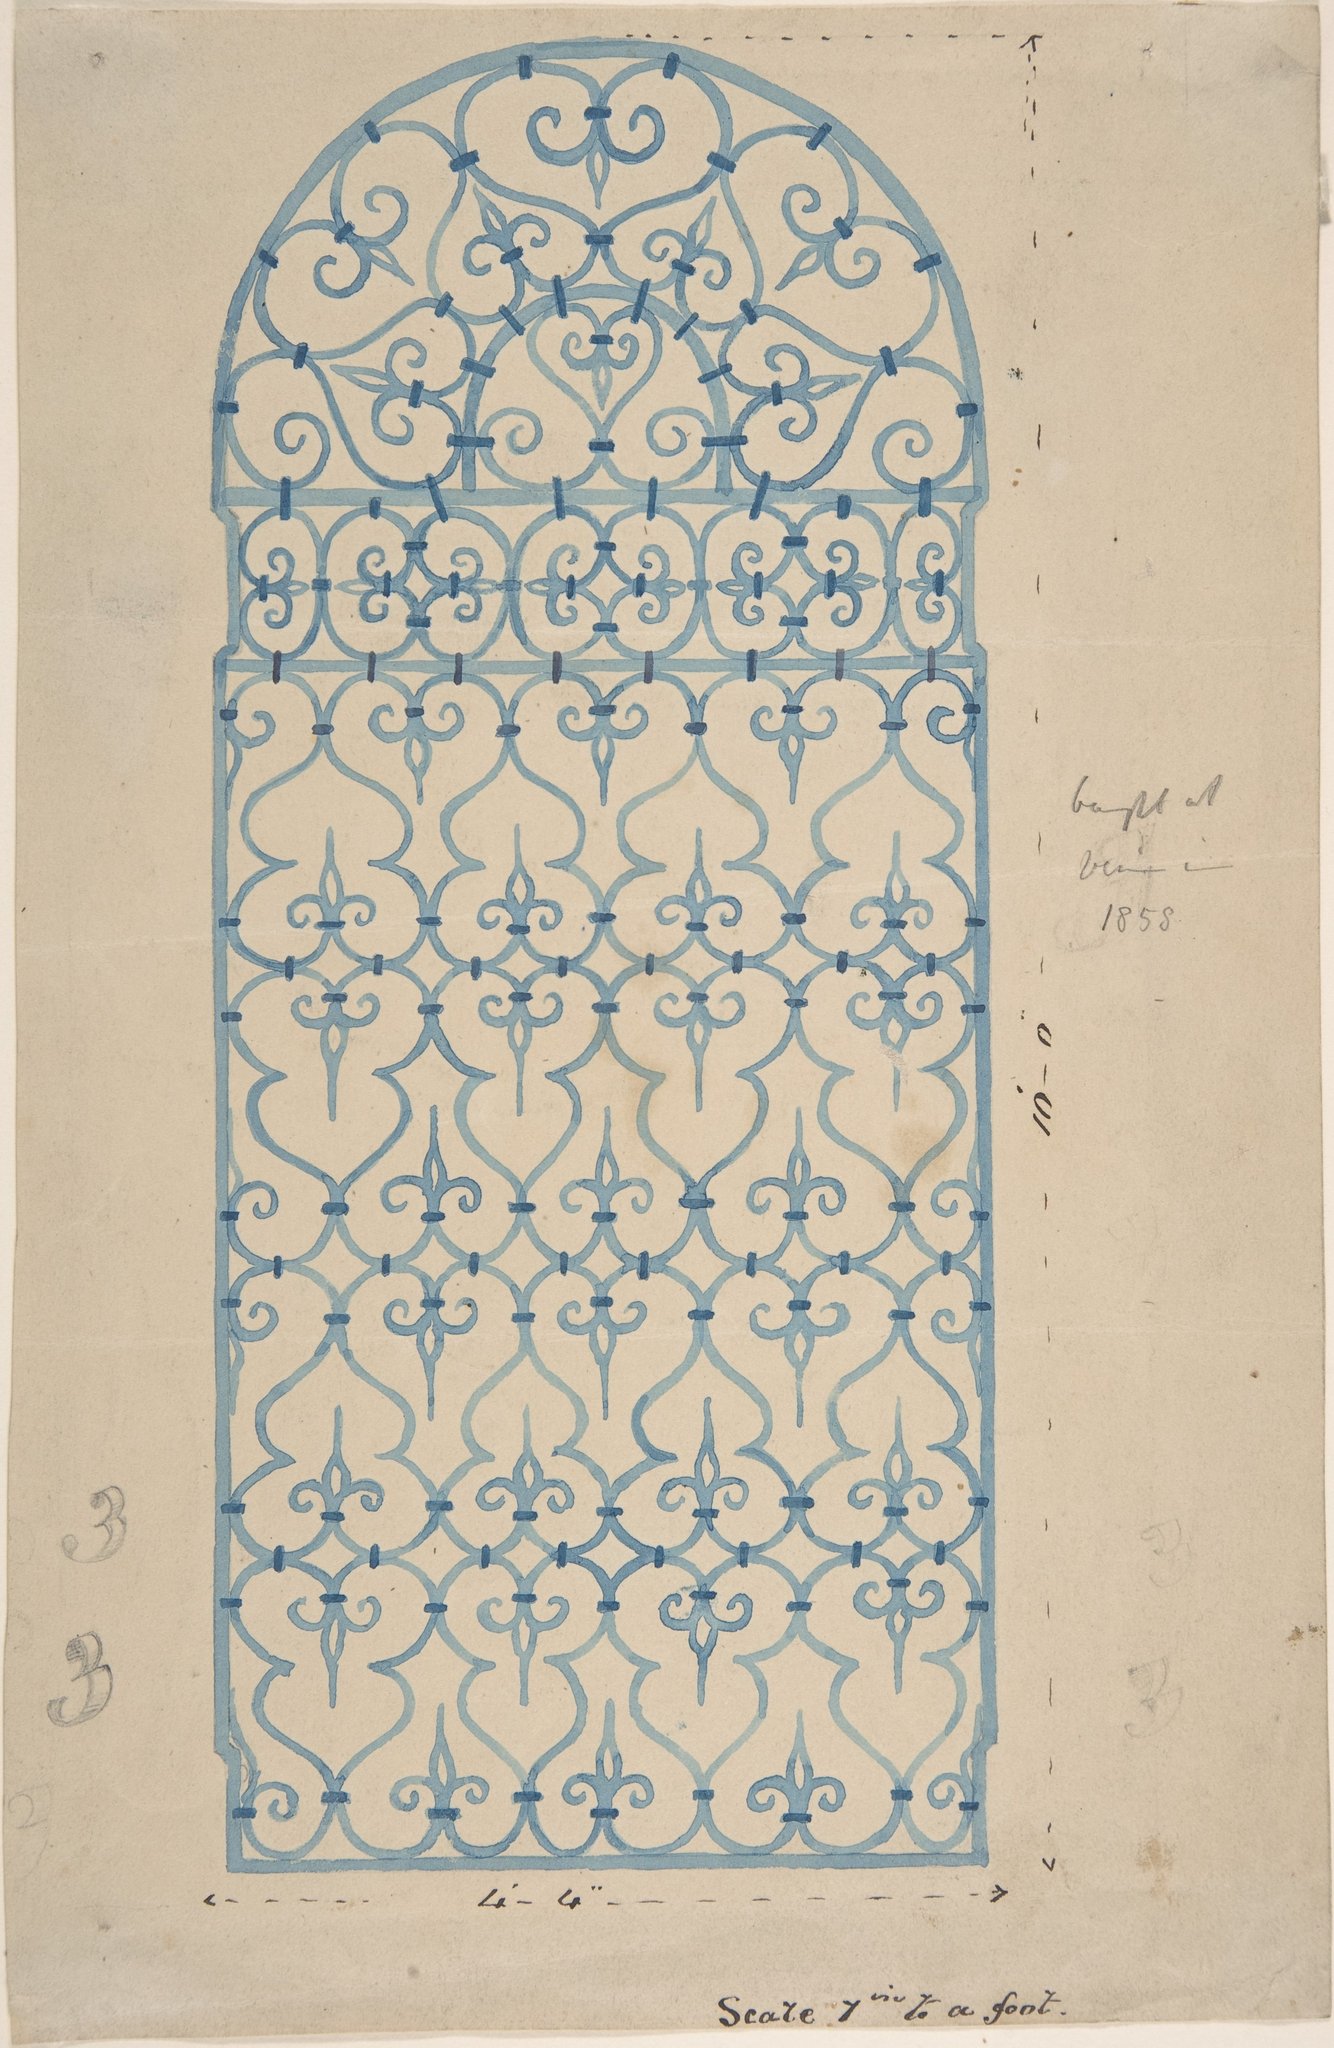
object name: drawing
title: Wrought Iron Gate Design (recto); Sketches for Bracket (verso)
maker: anonymous, british, 19th century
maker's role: artist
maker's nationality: british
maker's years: 1800-1900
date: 1870-1900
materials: graphite, watercolor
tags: gates